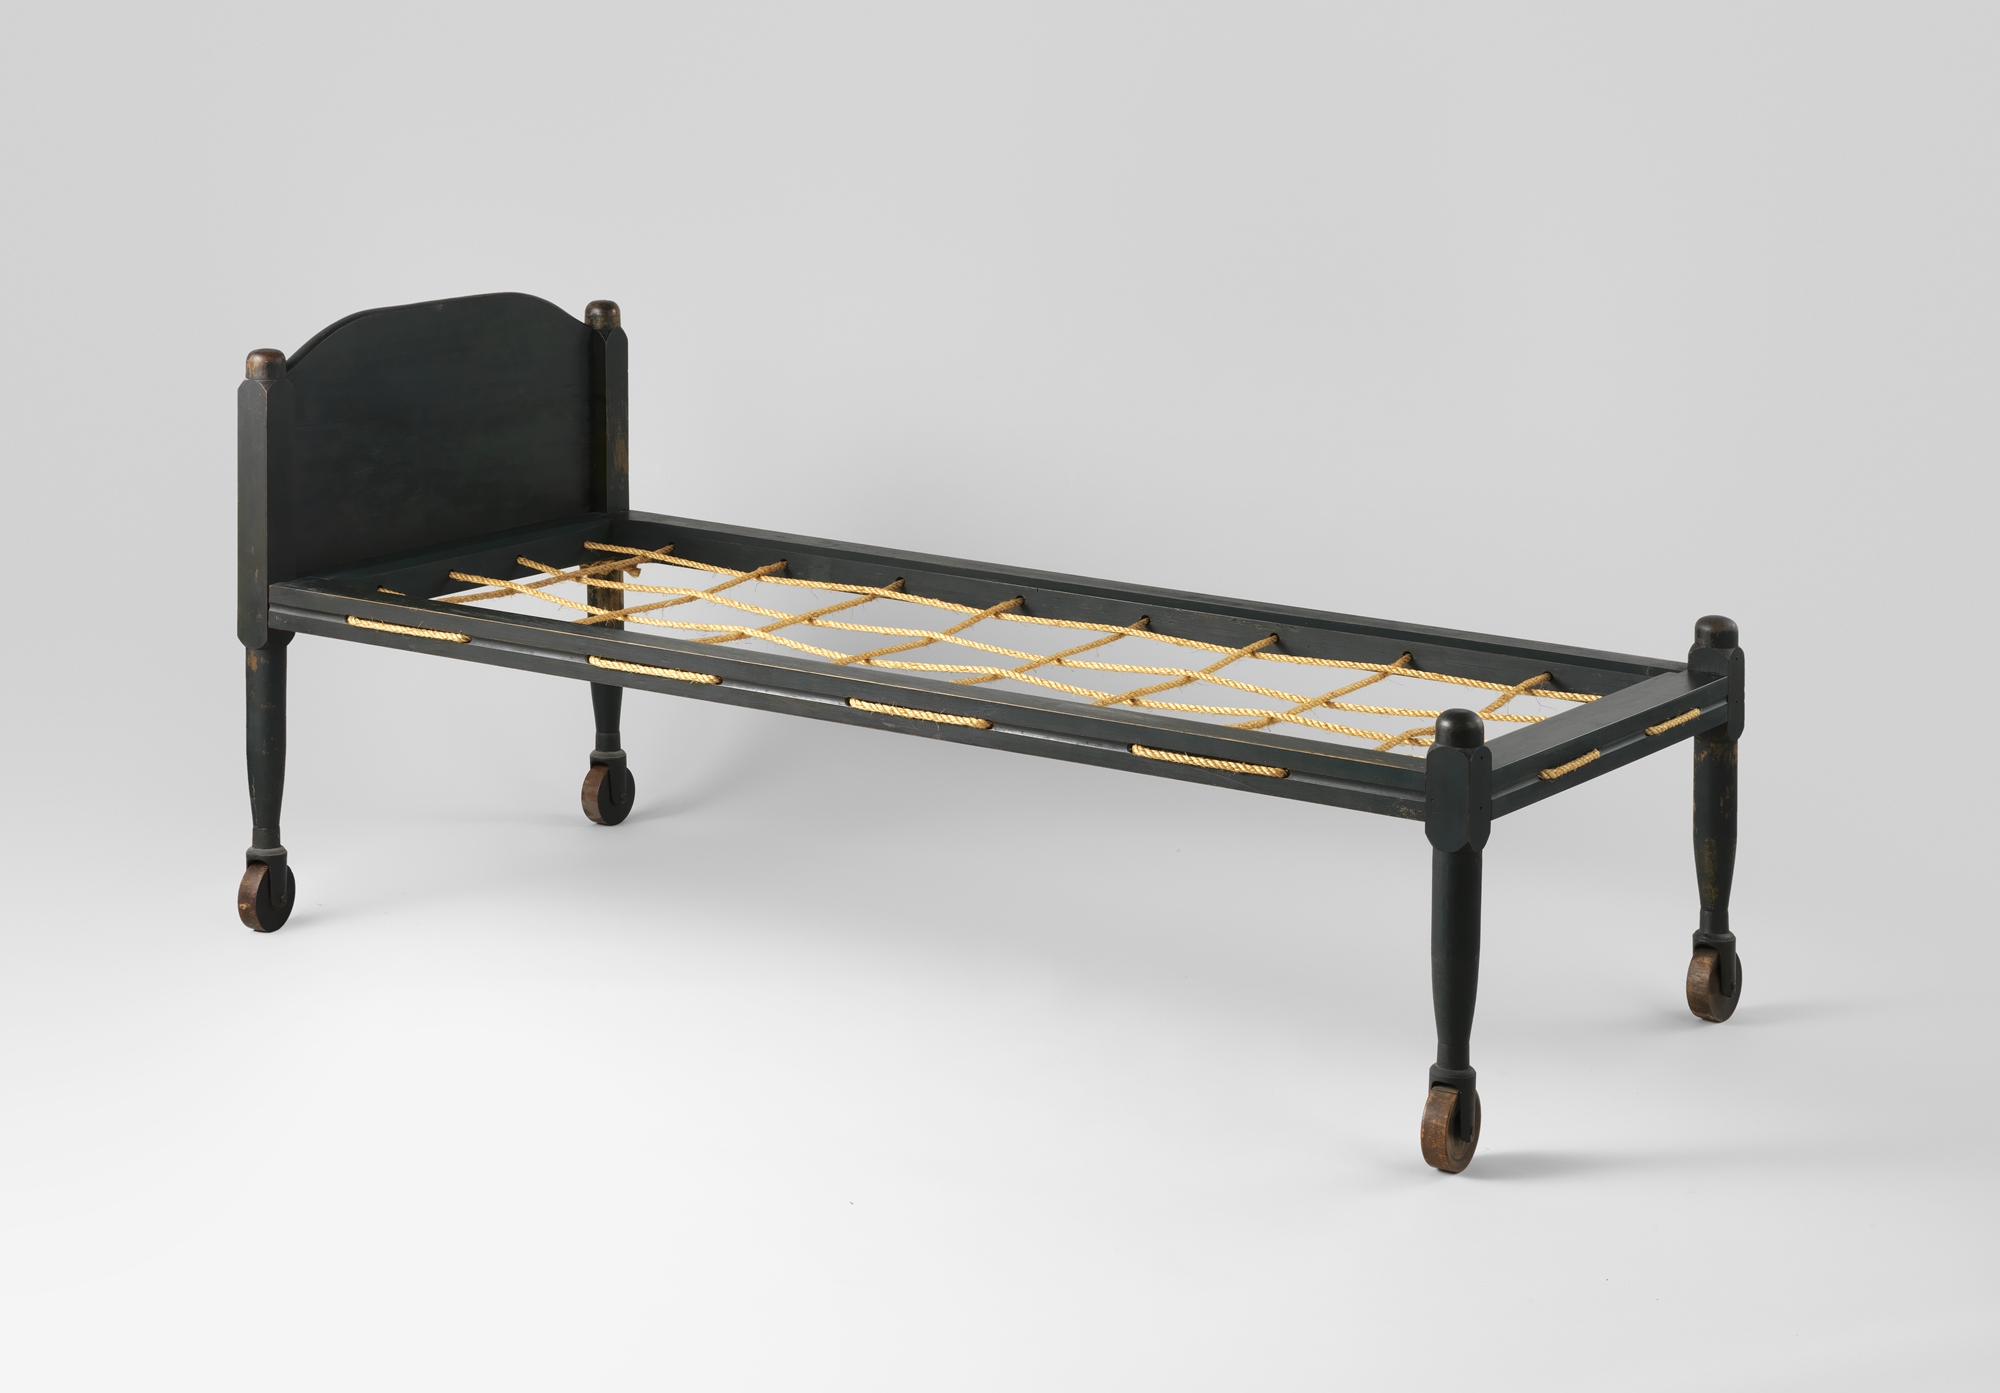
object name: bedstead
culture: american, shaker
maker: united society of believers in christ’s second appearing (“shakers”)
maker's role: maker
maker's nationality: american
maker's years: 1750-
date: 1830-1860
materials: wood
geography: united states